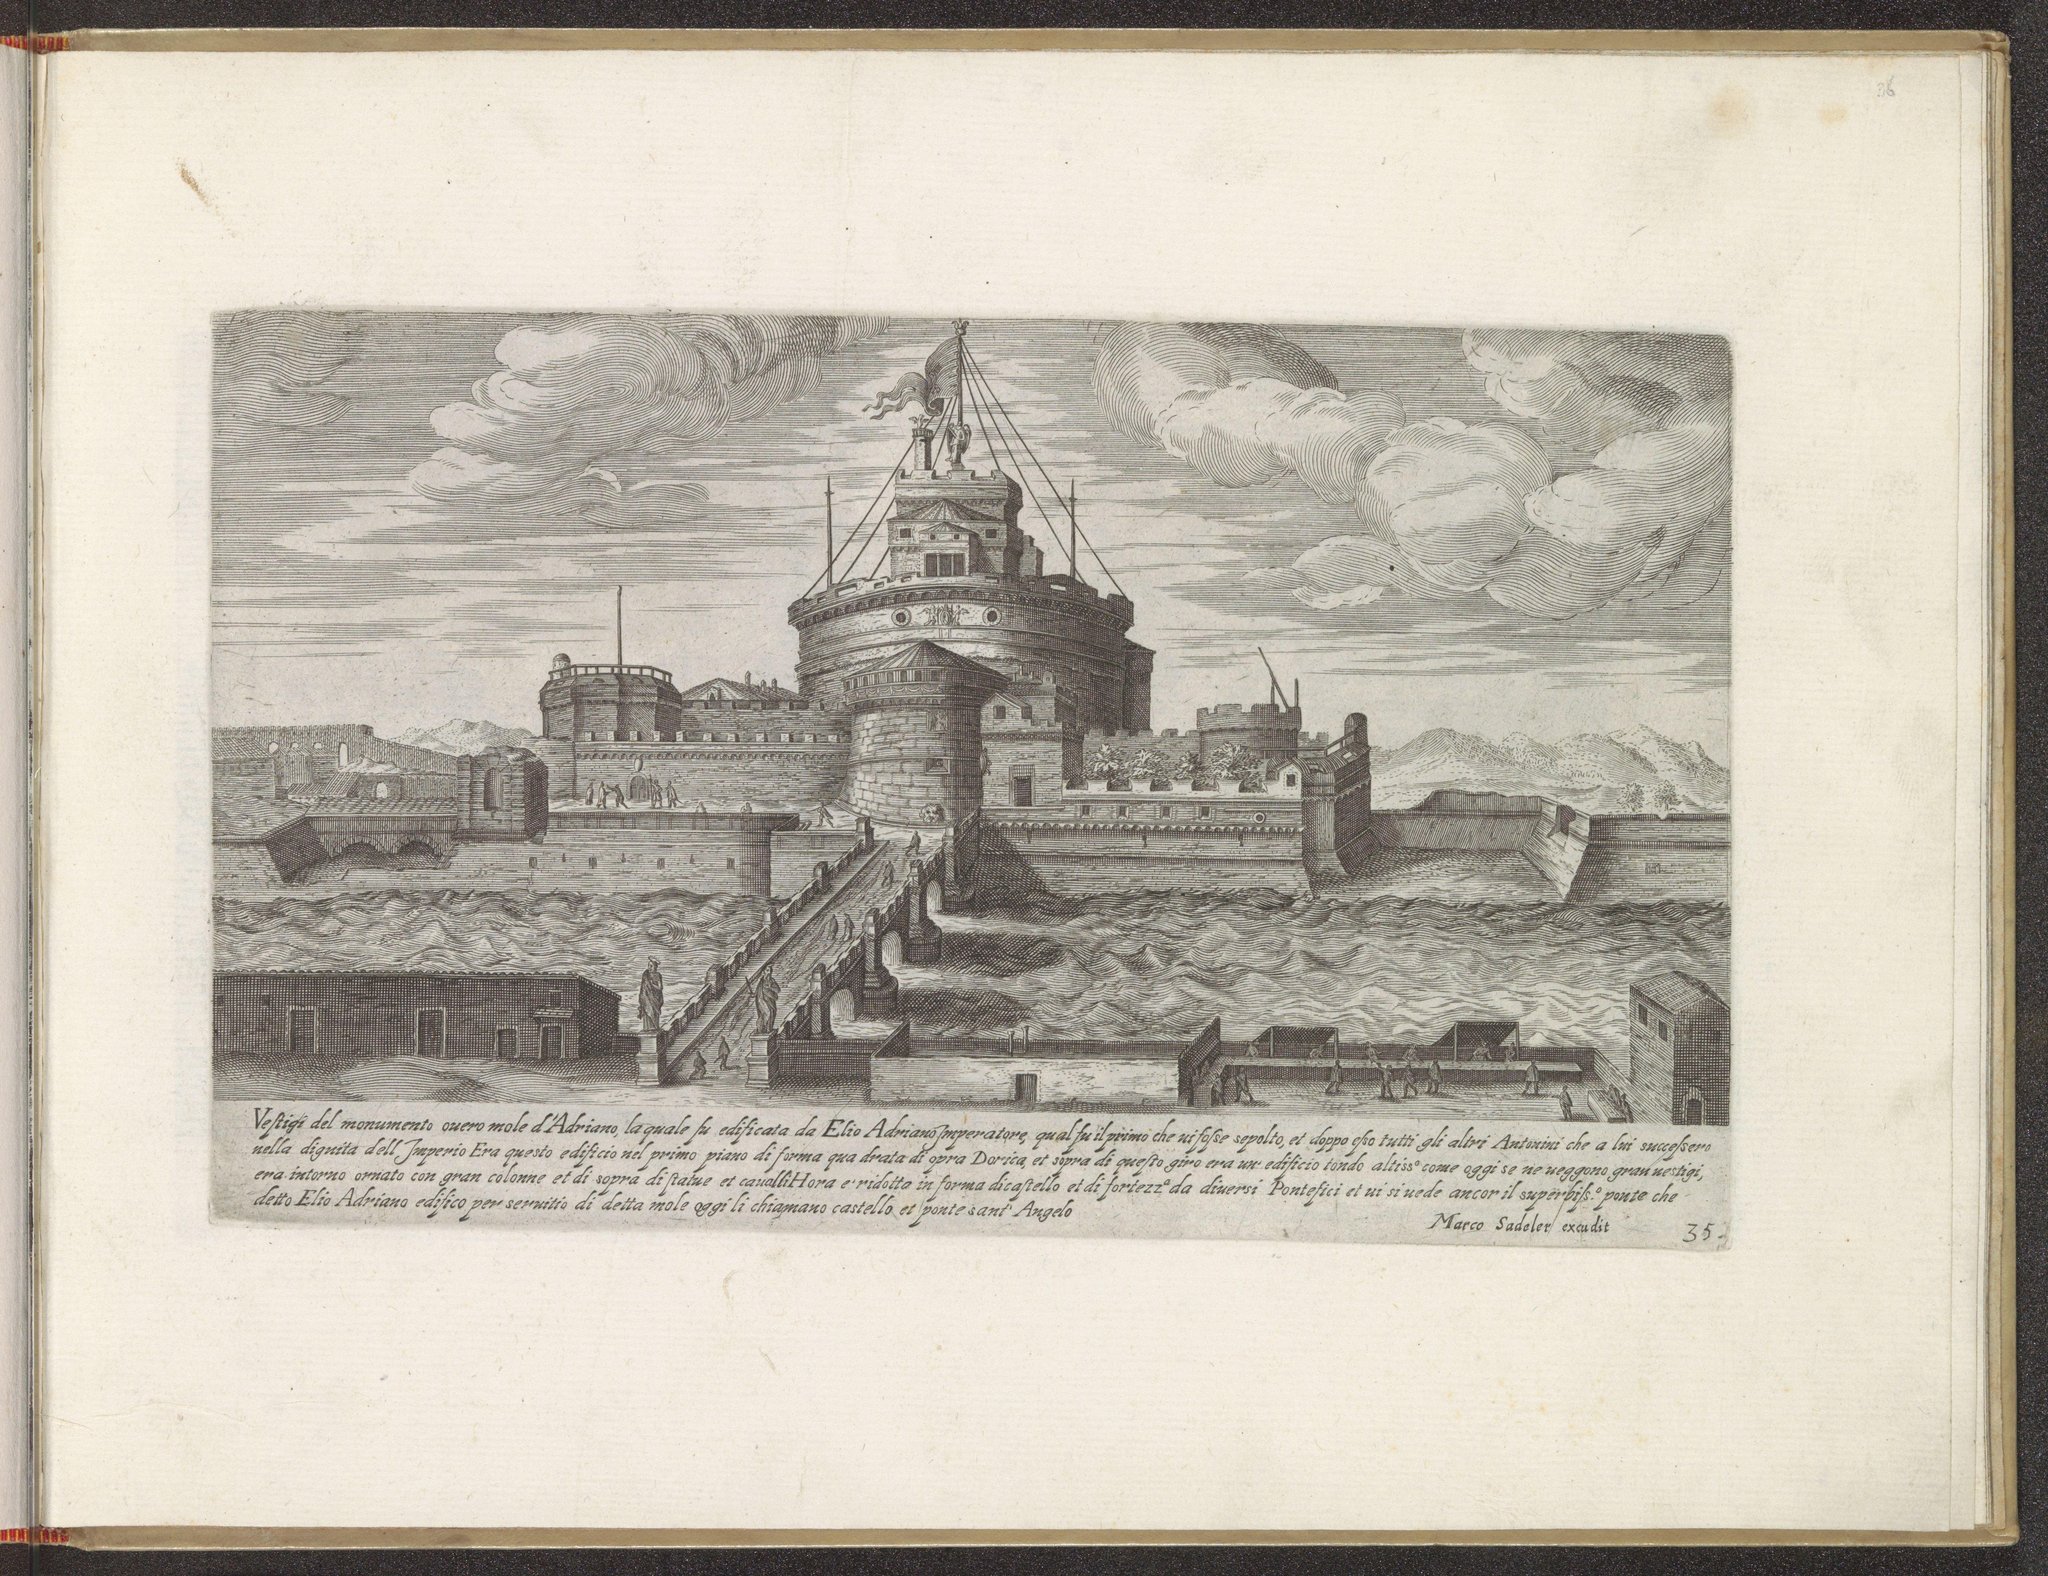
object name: album leaf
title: Engelenburcht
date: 1606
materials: paper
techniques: engraving, etching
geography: prague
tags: rome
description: De Engelenburcht, oorspronkelijk Moles Hadriani ('het gevaarte van Hadrianus'), het grote mausoleum van keizer Hadrianus. In de ondermarge vier regels tekst in het Italiaans. De prent maakt deel uit van een album.